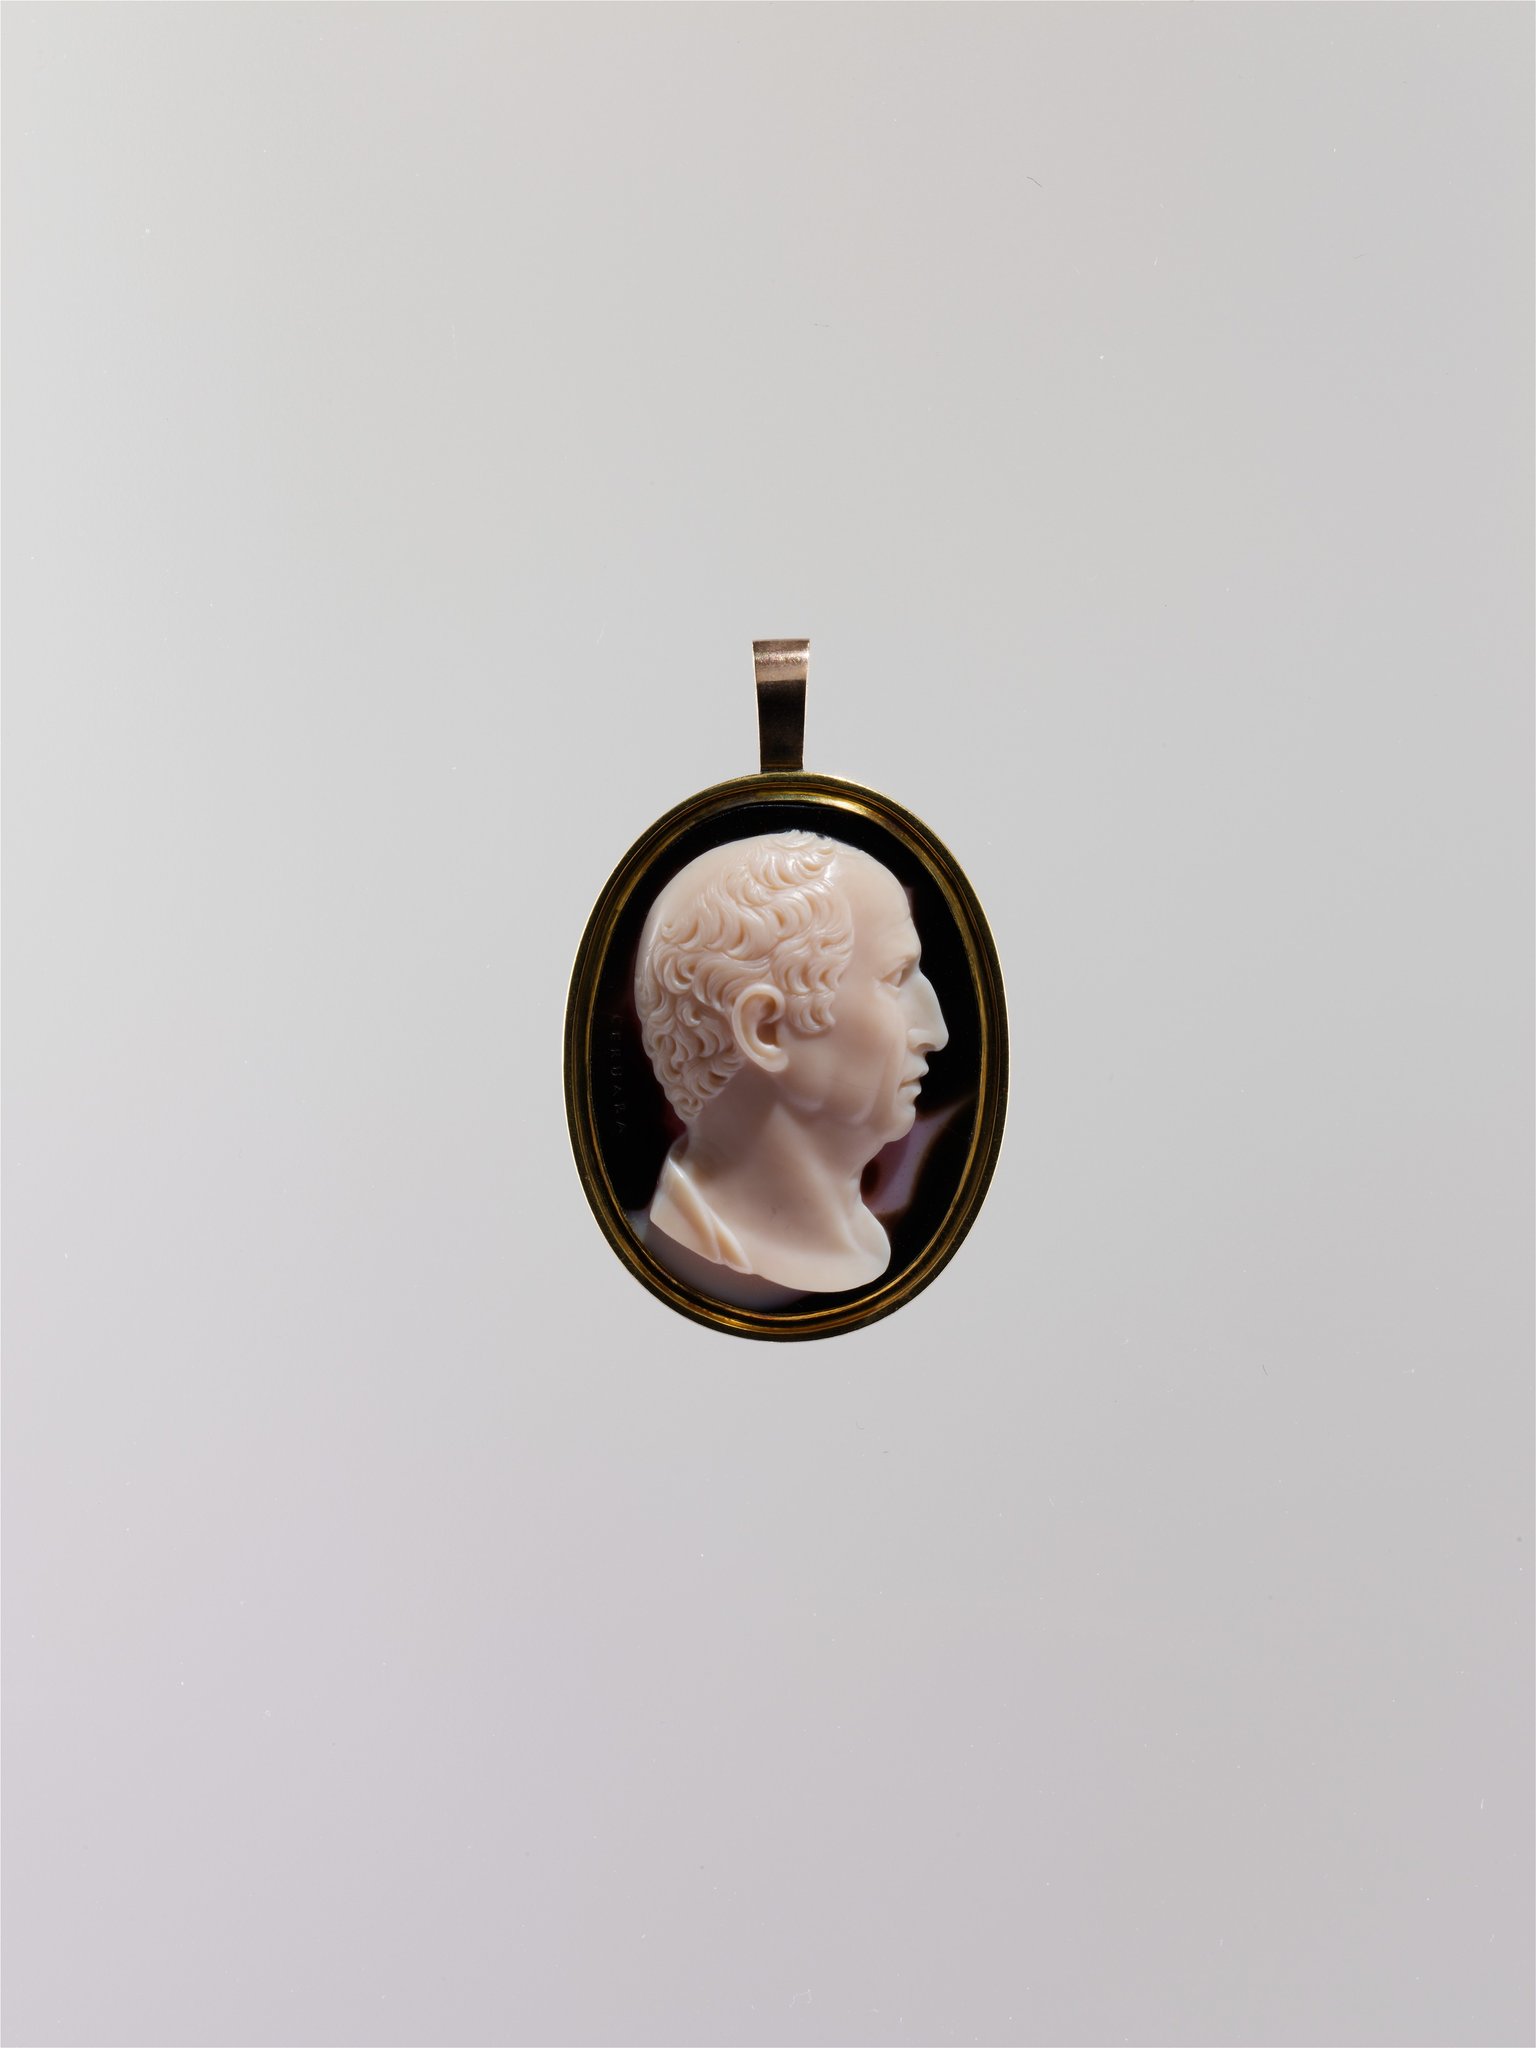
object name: cameo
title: Cicero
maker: niccolò cerbara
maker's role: maker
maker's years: 1793-1869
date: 1810-1820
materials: gemstone, silver gilt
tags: men,profiles